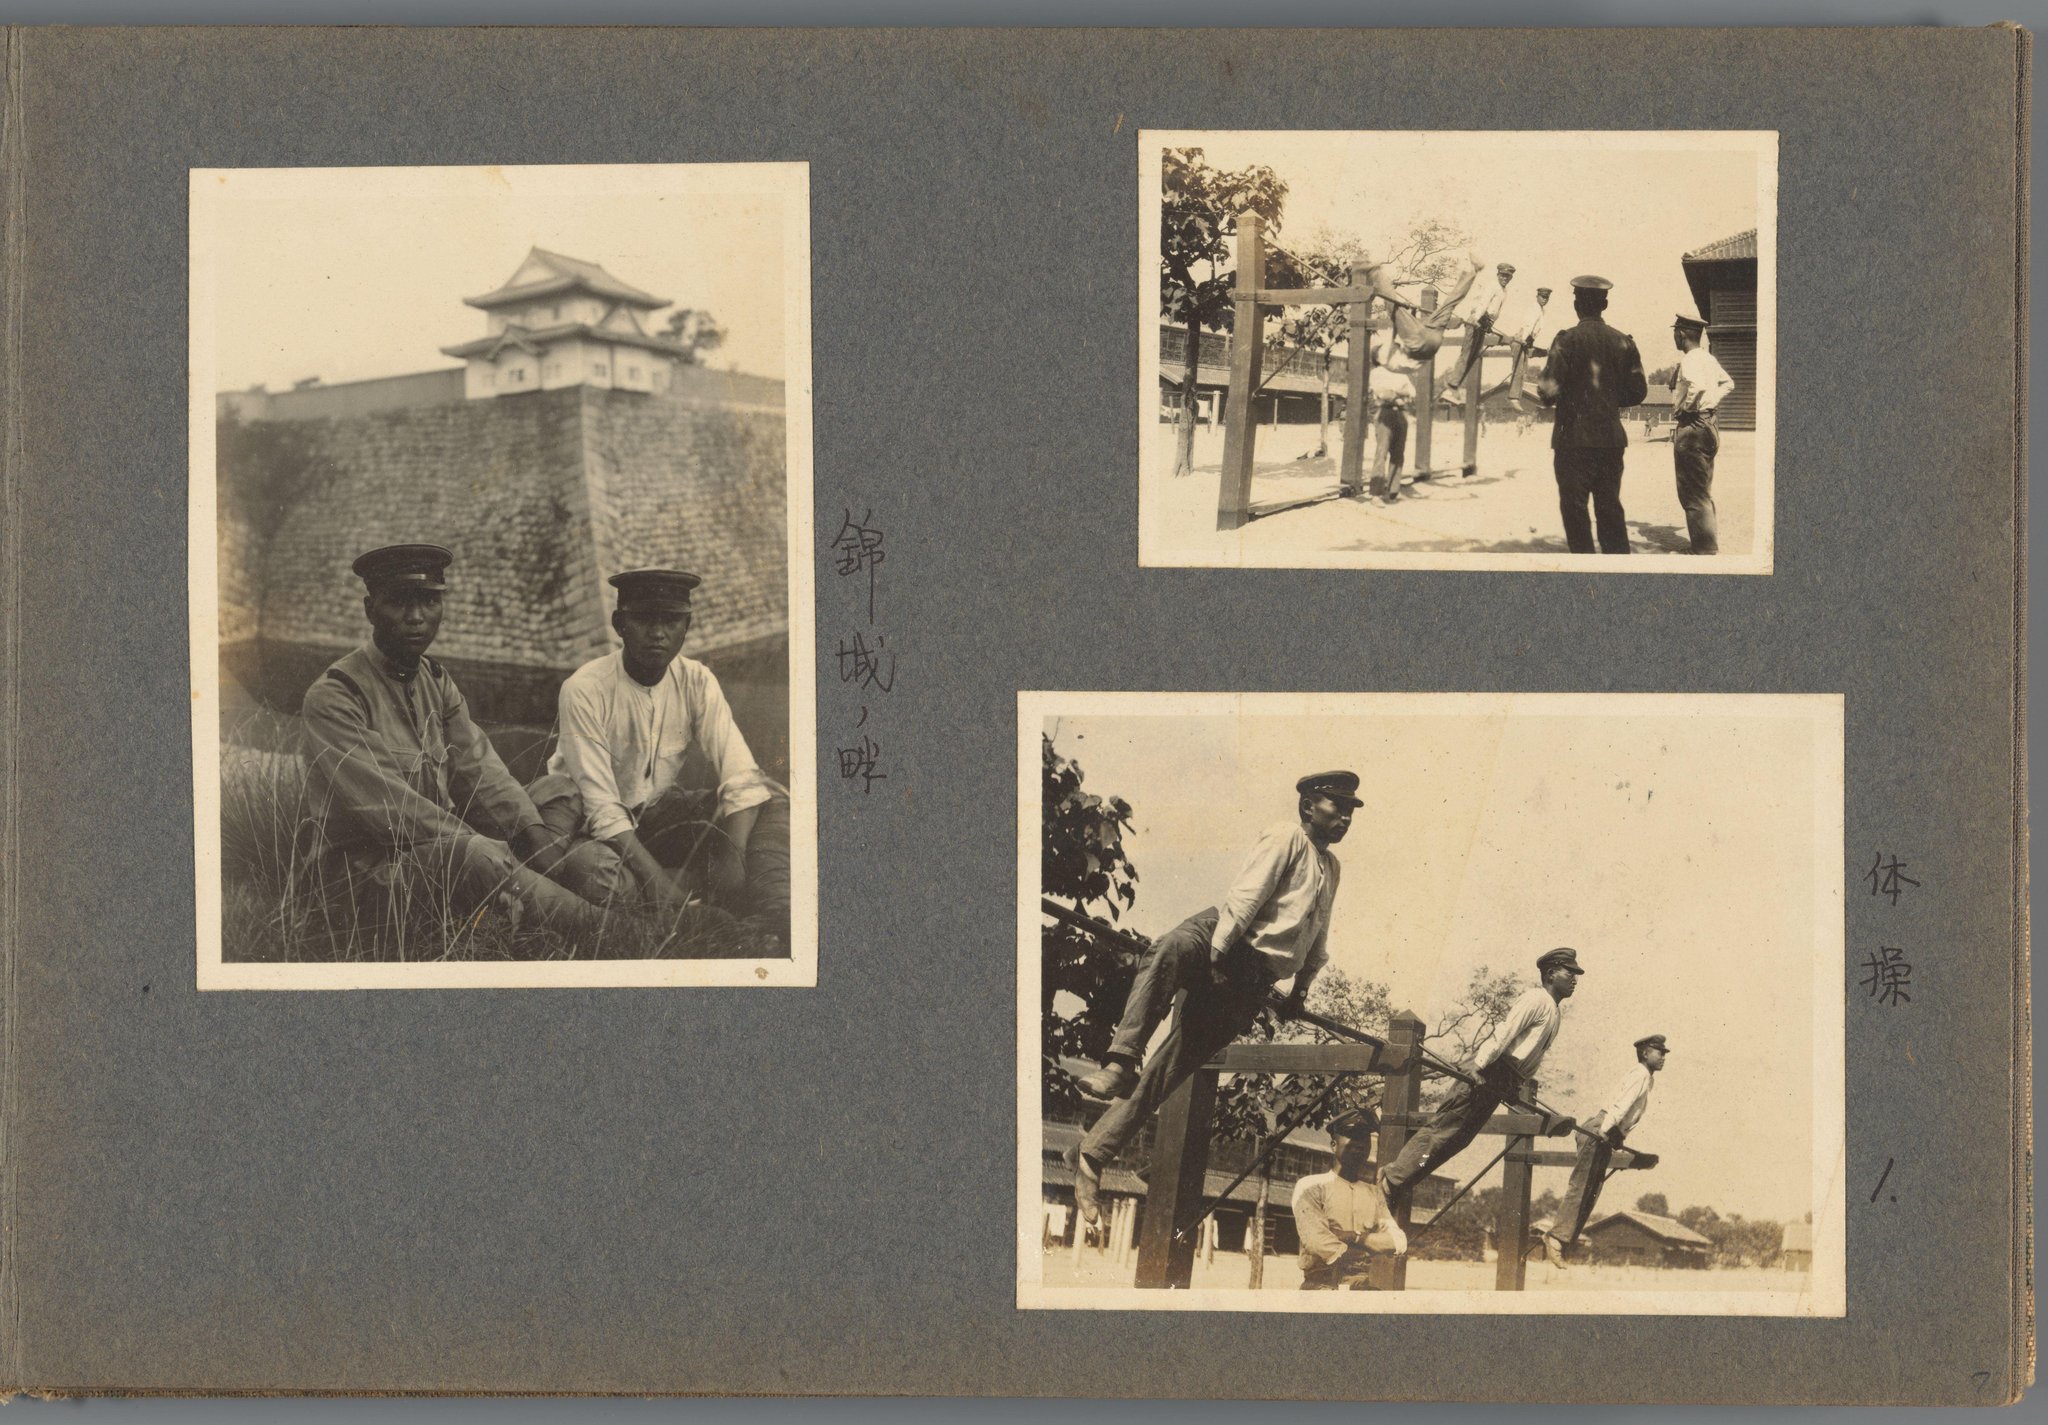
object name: album leaf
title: Bezoek aan een kasteel en fysieke training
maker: Anonymous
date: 1930-1940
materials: cardboard, photographic support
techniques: gelatin silver print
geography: japan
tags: castle, other physical exercise ~ military training, military training, japan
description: Albumblad met drie foto's van het leven van Japanse militairen. Bij de foto's opschriften in het Japans. Onderdeel van het leporello fotoalbum met foto’s van de diensttijd van Japanse militairen.